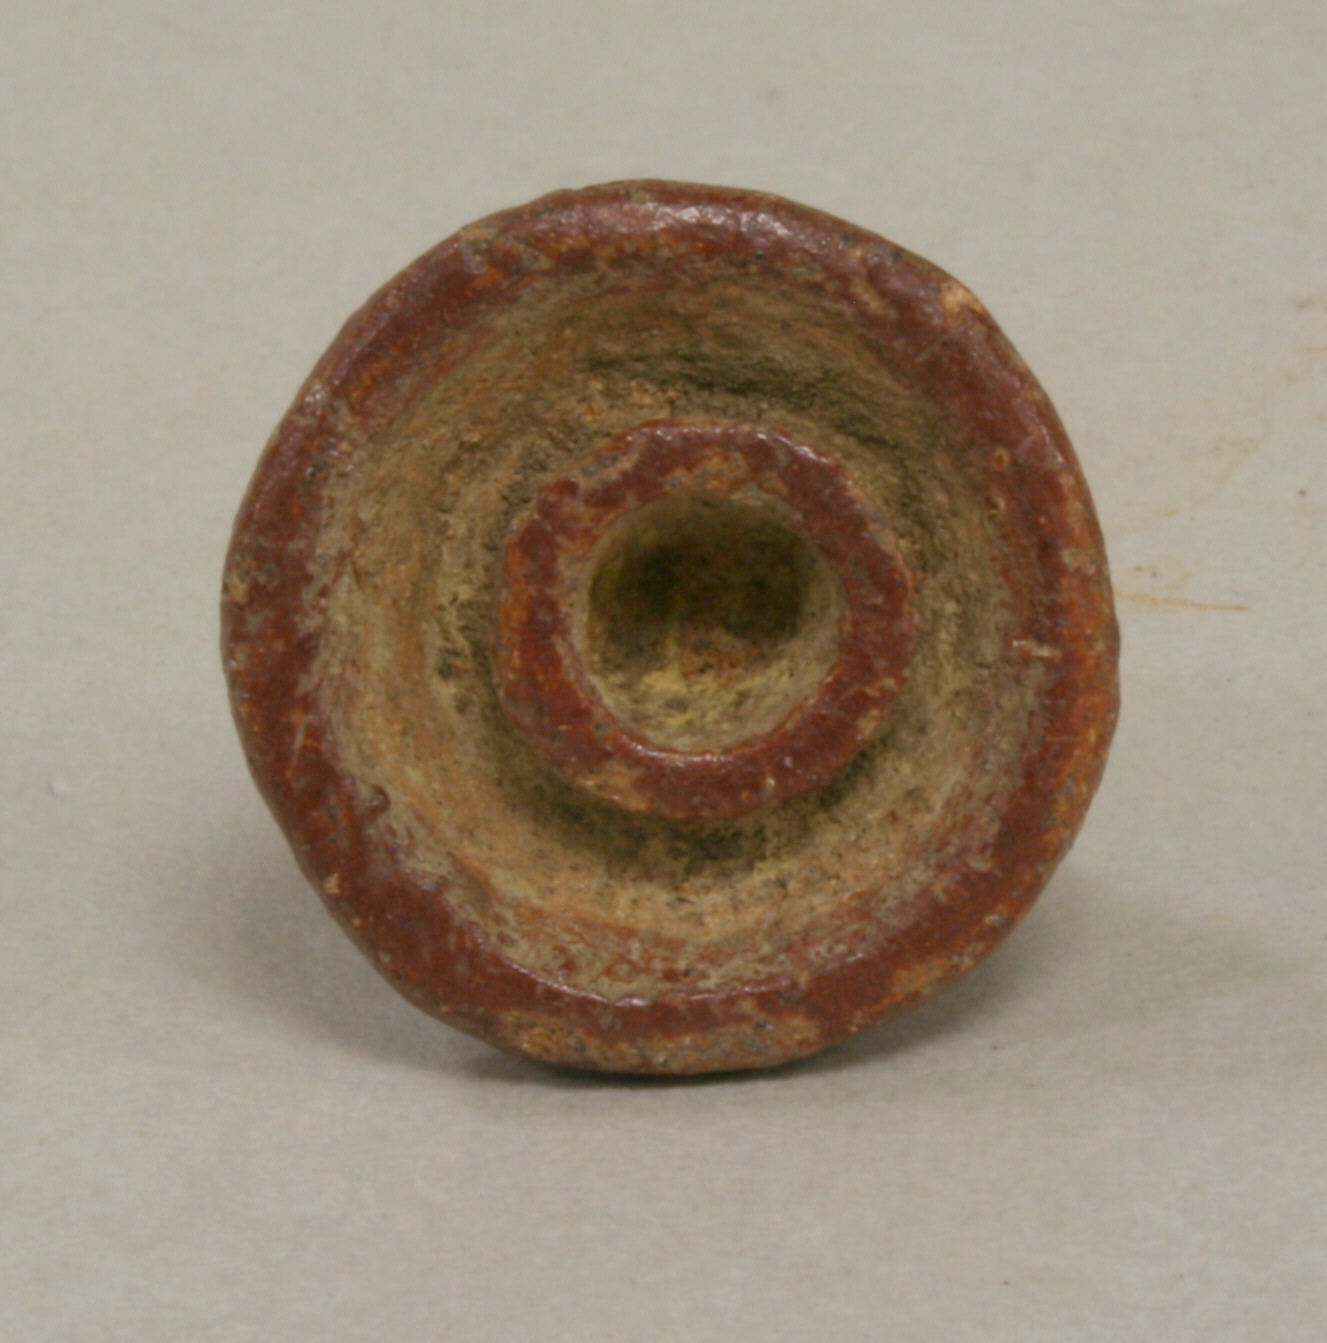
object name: stamp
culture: atlantic watershed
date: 401-600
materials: ceramic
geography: costa rica